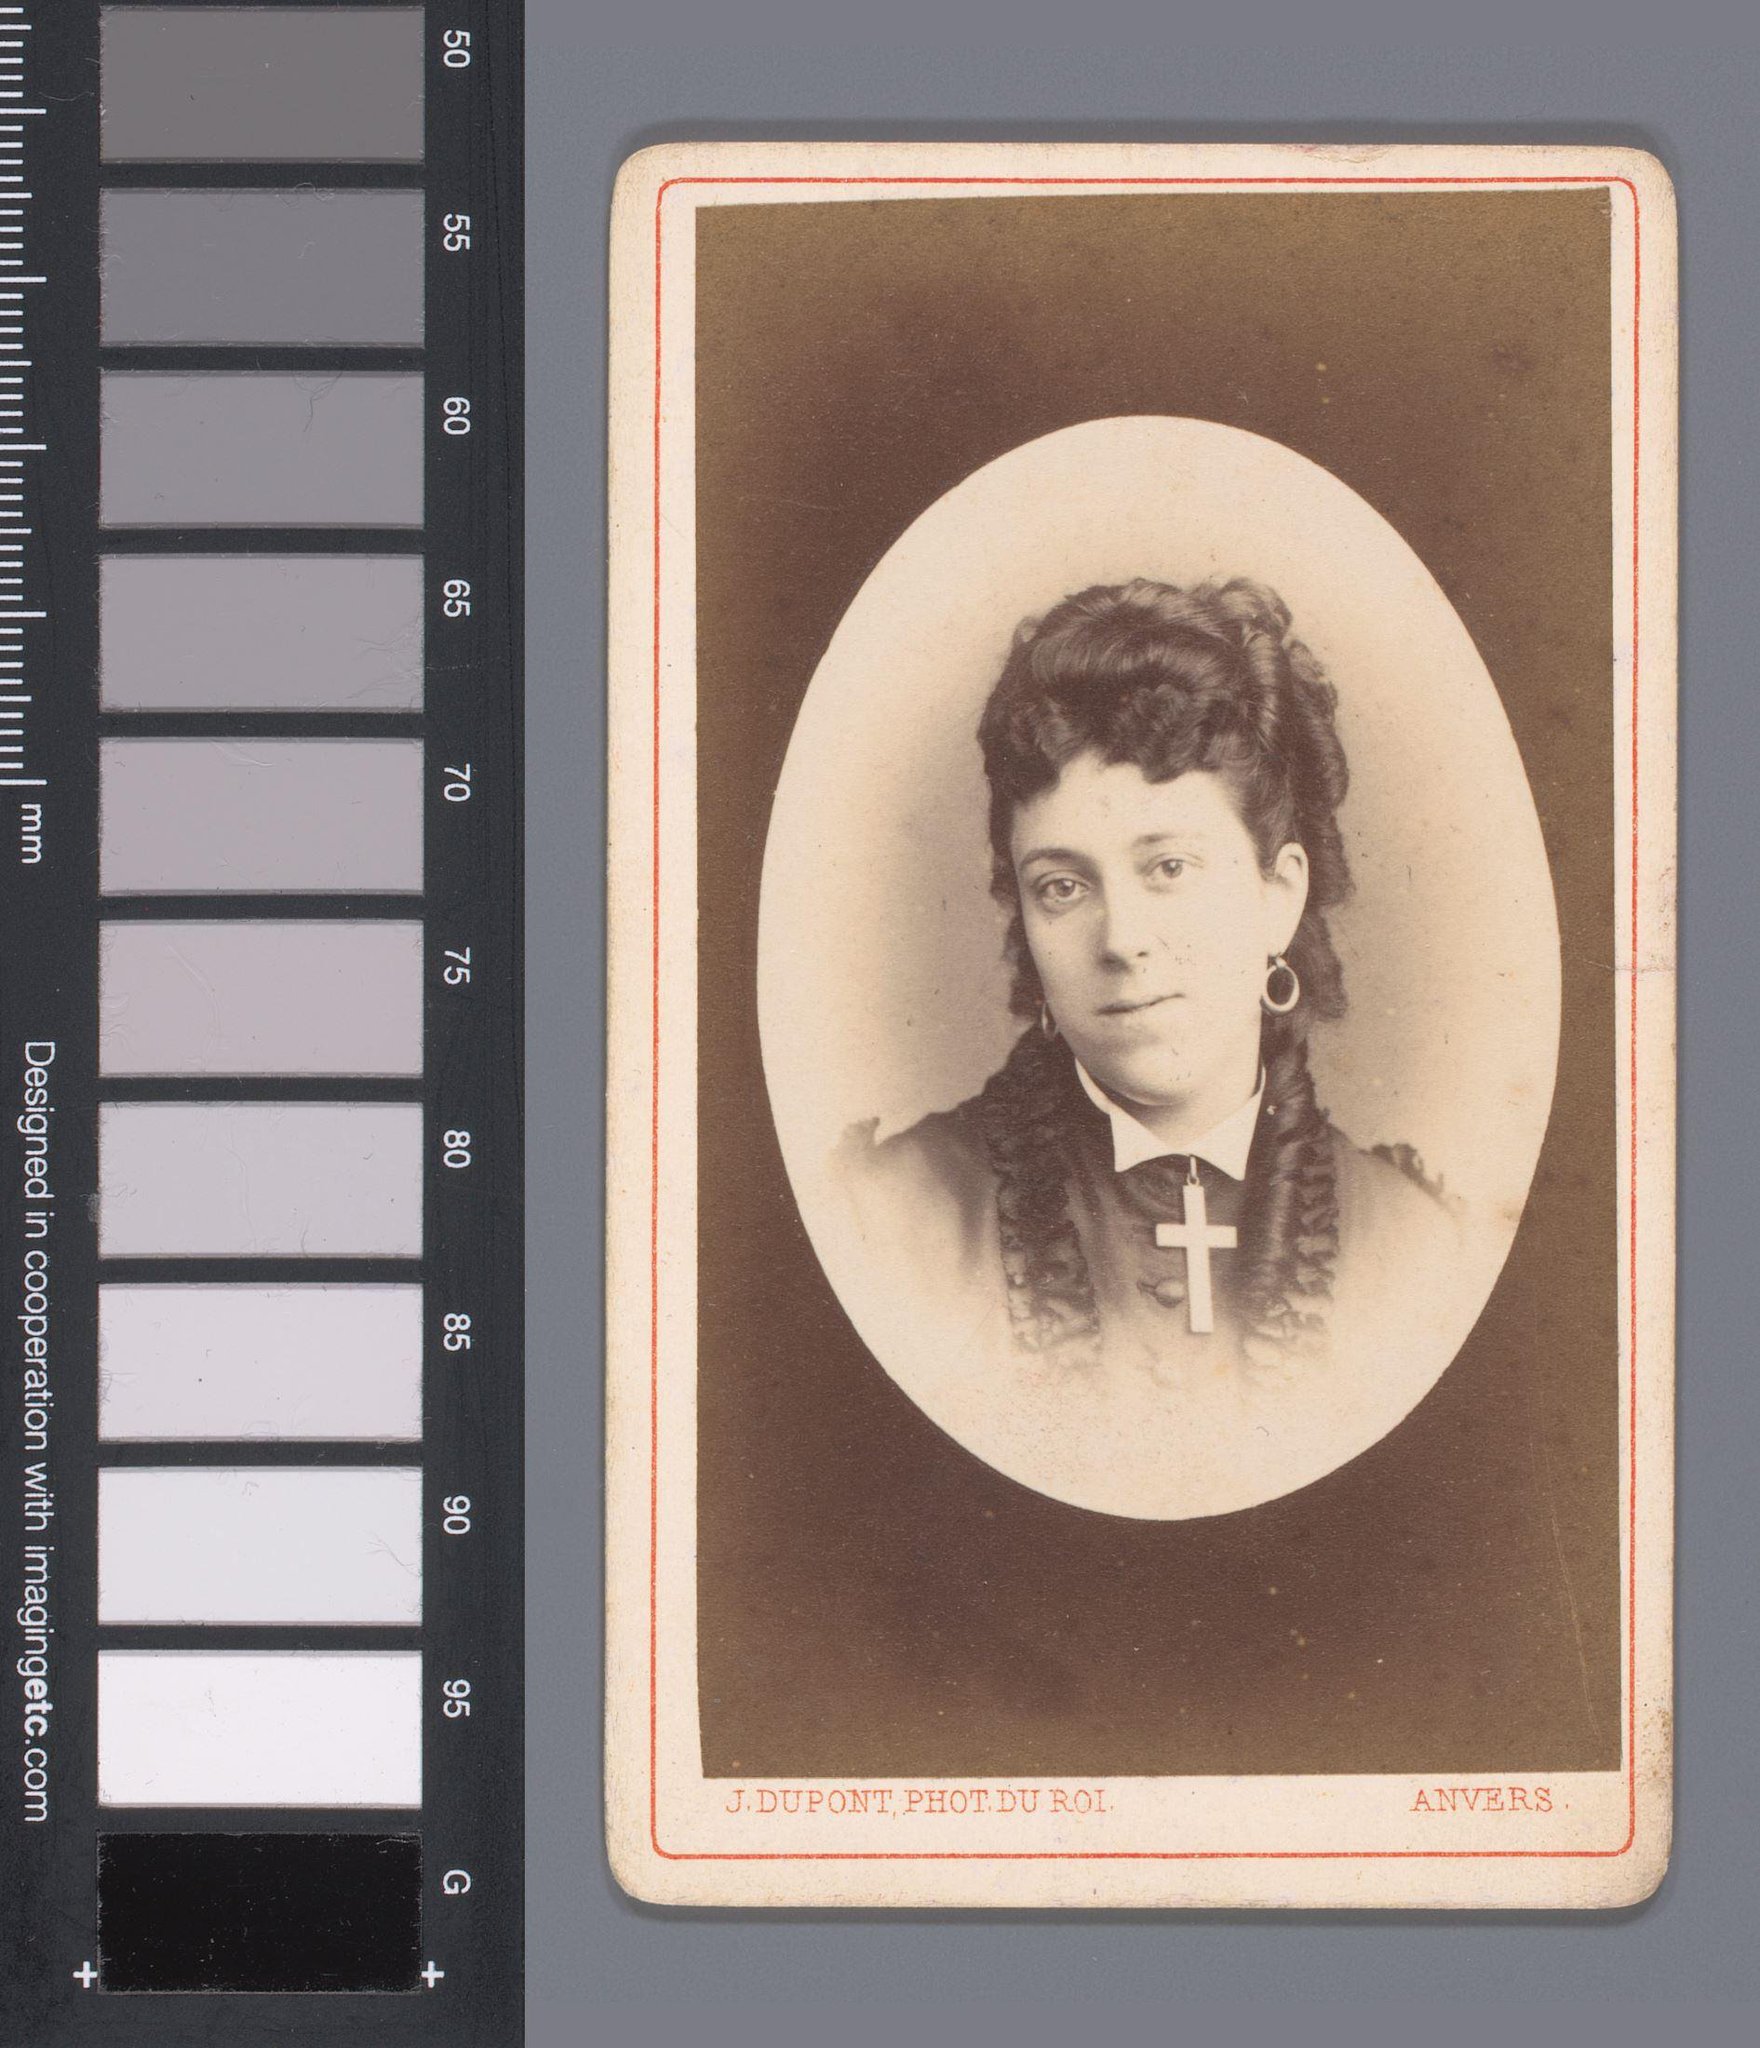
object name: semi enamel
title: Portret van een onbekende vrouw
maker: joseph dupont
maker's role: fotograaf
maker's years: 1818-1901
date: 1859-1873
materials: cardboard, celluloid, paper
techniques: albumen print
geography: antwerp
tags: adult woman, anonymous historical person portrayed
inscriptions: inscription: ‘Photographe de Roi/ MAISON FONDÉE EN 1853./ Tous les Clichés ont été conservés.’, address: ‘Place de Meir, 32/ Anvers’